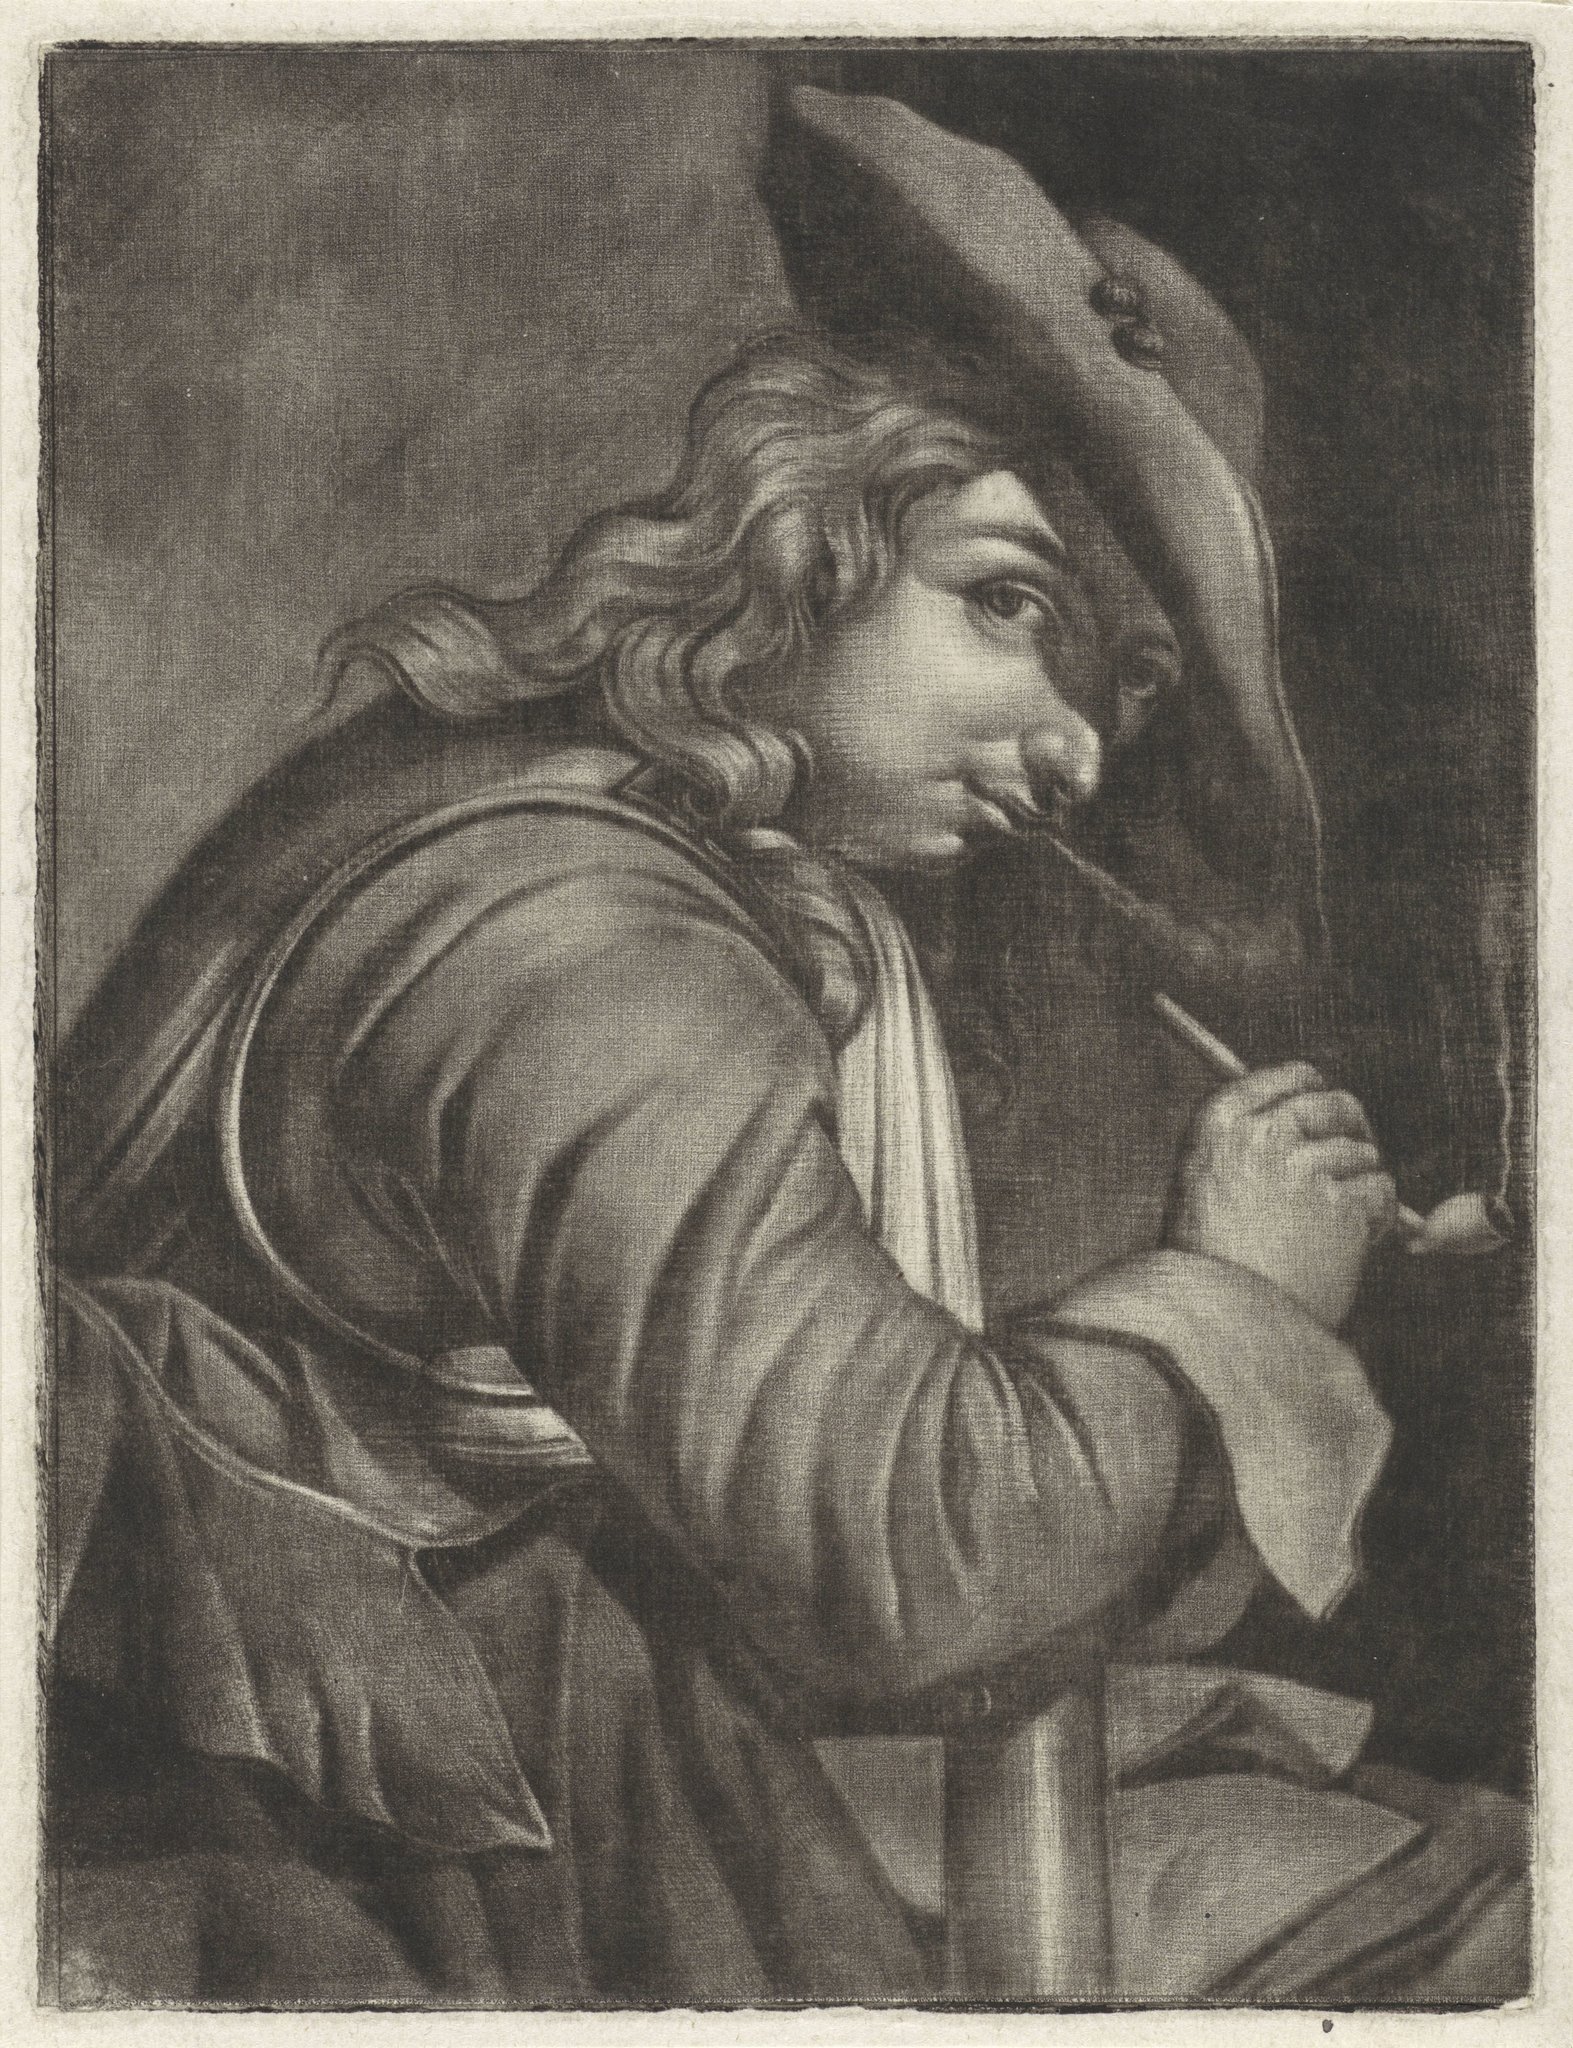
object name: print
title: Jonge pijprokende man met een hoed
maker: jacob toorenvliet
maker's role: draughtsman, painter, print maker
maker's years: 1640-1719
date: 1651-1719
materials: paper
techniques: mezzotint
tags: pipe ~ tobacco, head-gear: hat (+ men's clothes)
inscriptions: collector's mark: Lugt 2228